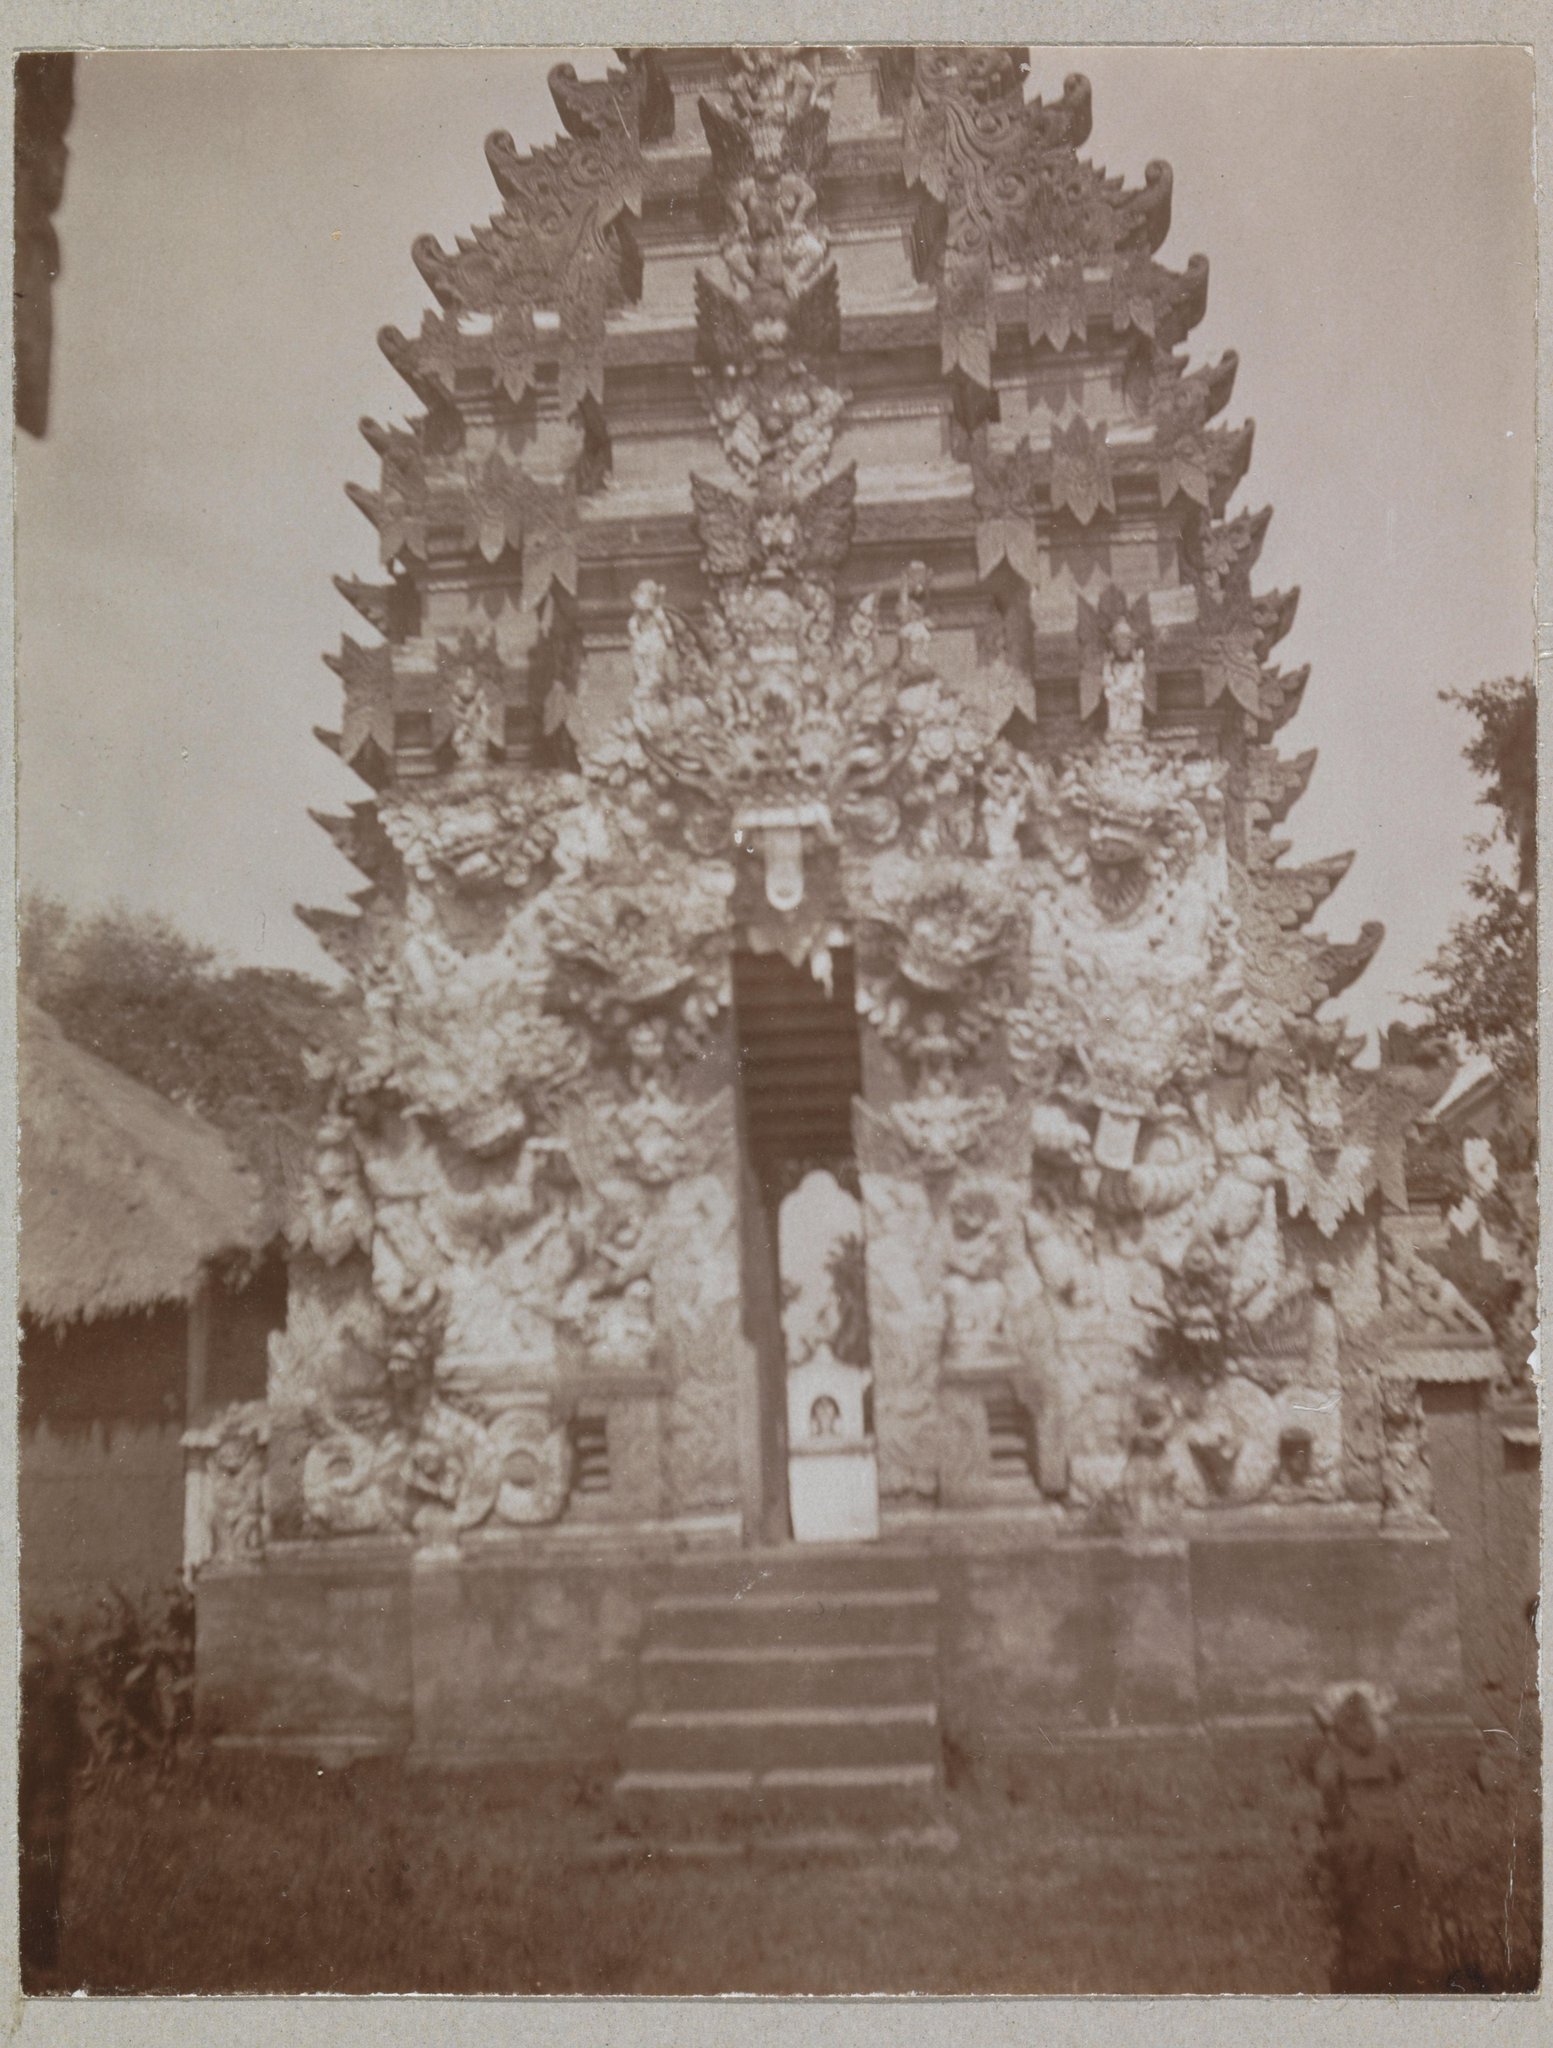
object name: photograph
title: Tempelpoort, Bali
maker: Anonymous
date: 1895-1915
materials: cardboard, paper, photographic support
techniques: collodion silver print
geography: bali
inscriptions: annotation: ‘4) tempelpoort op Bali.’